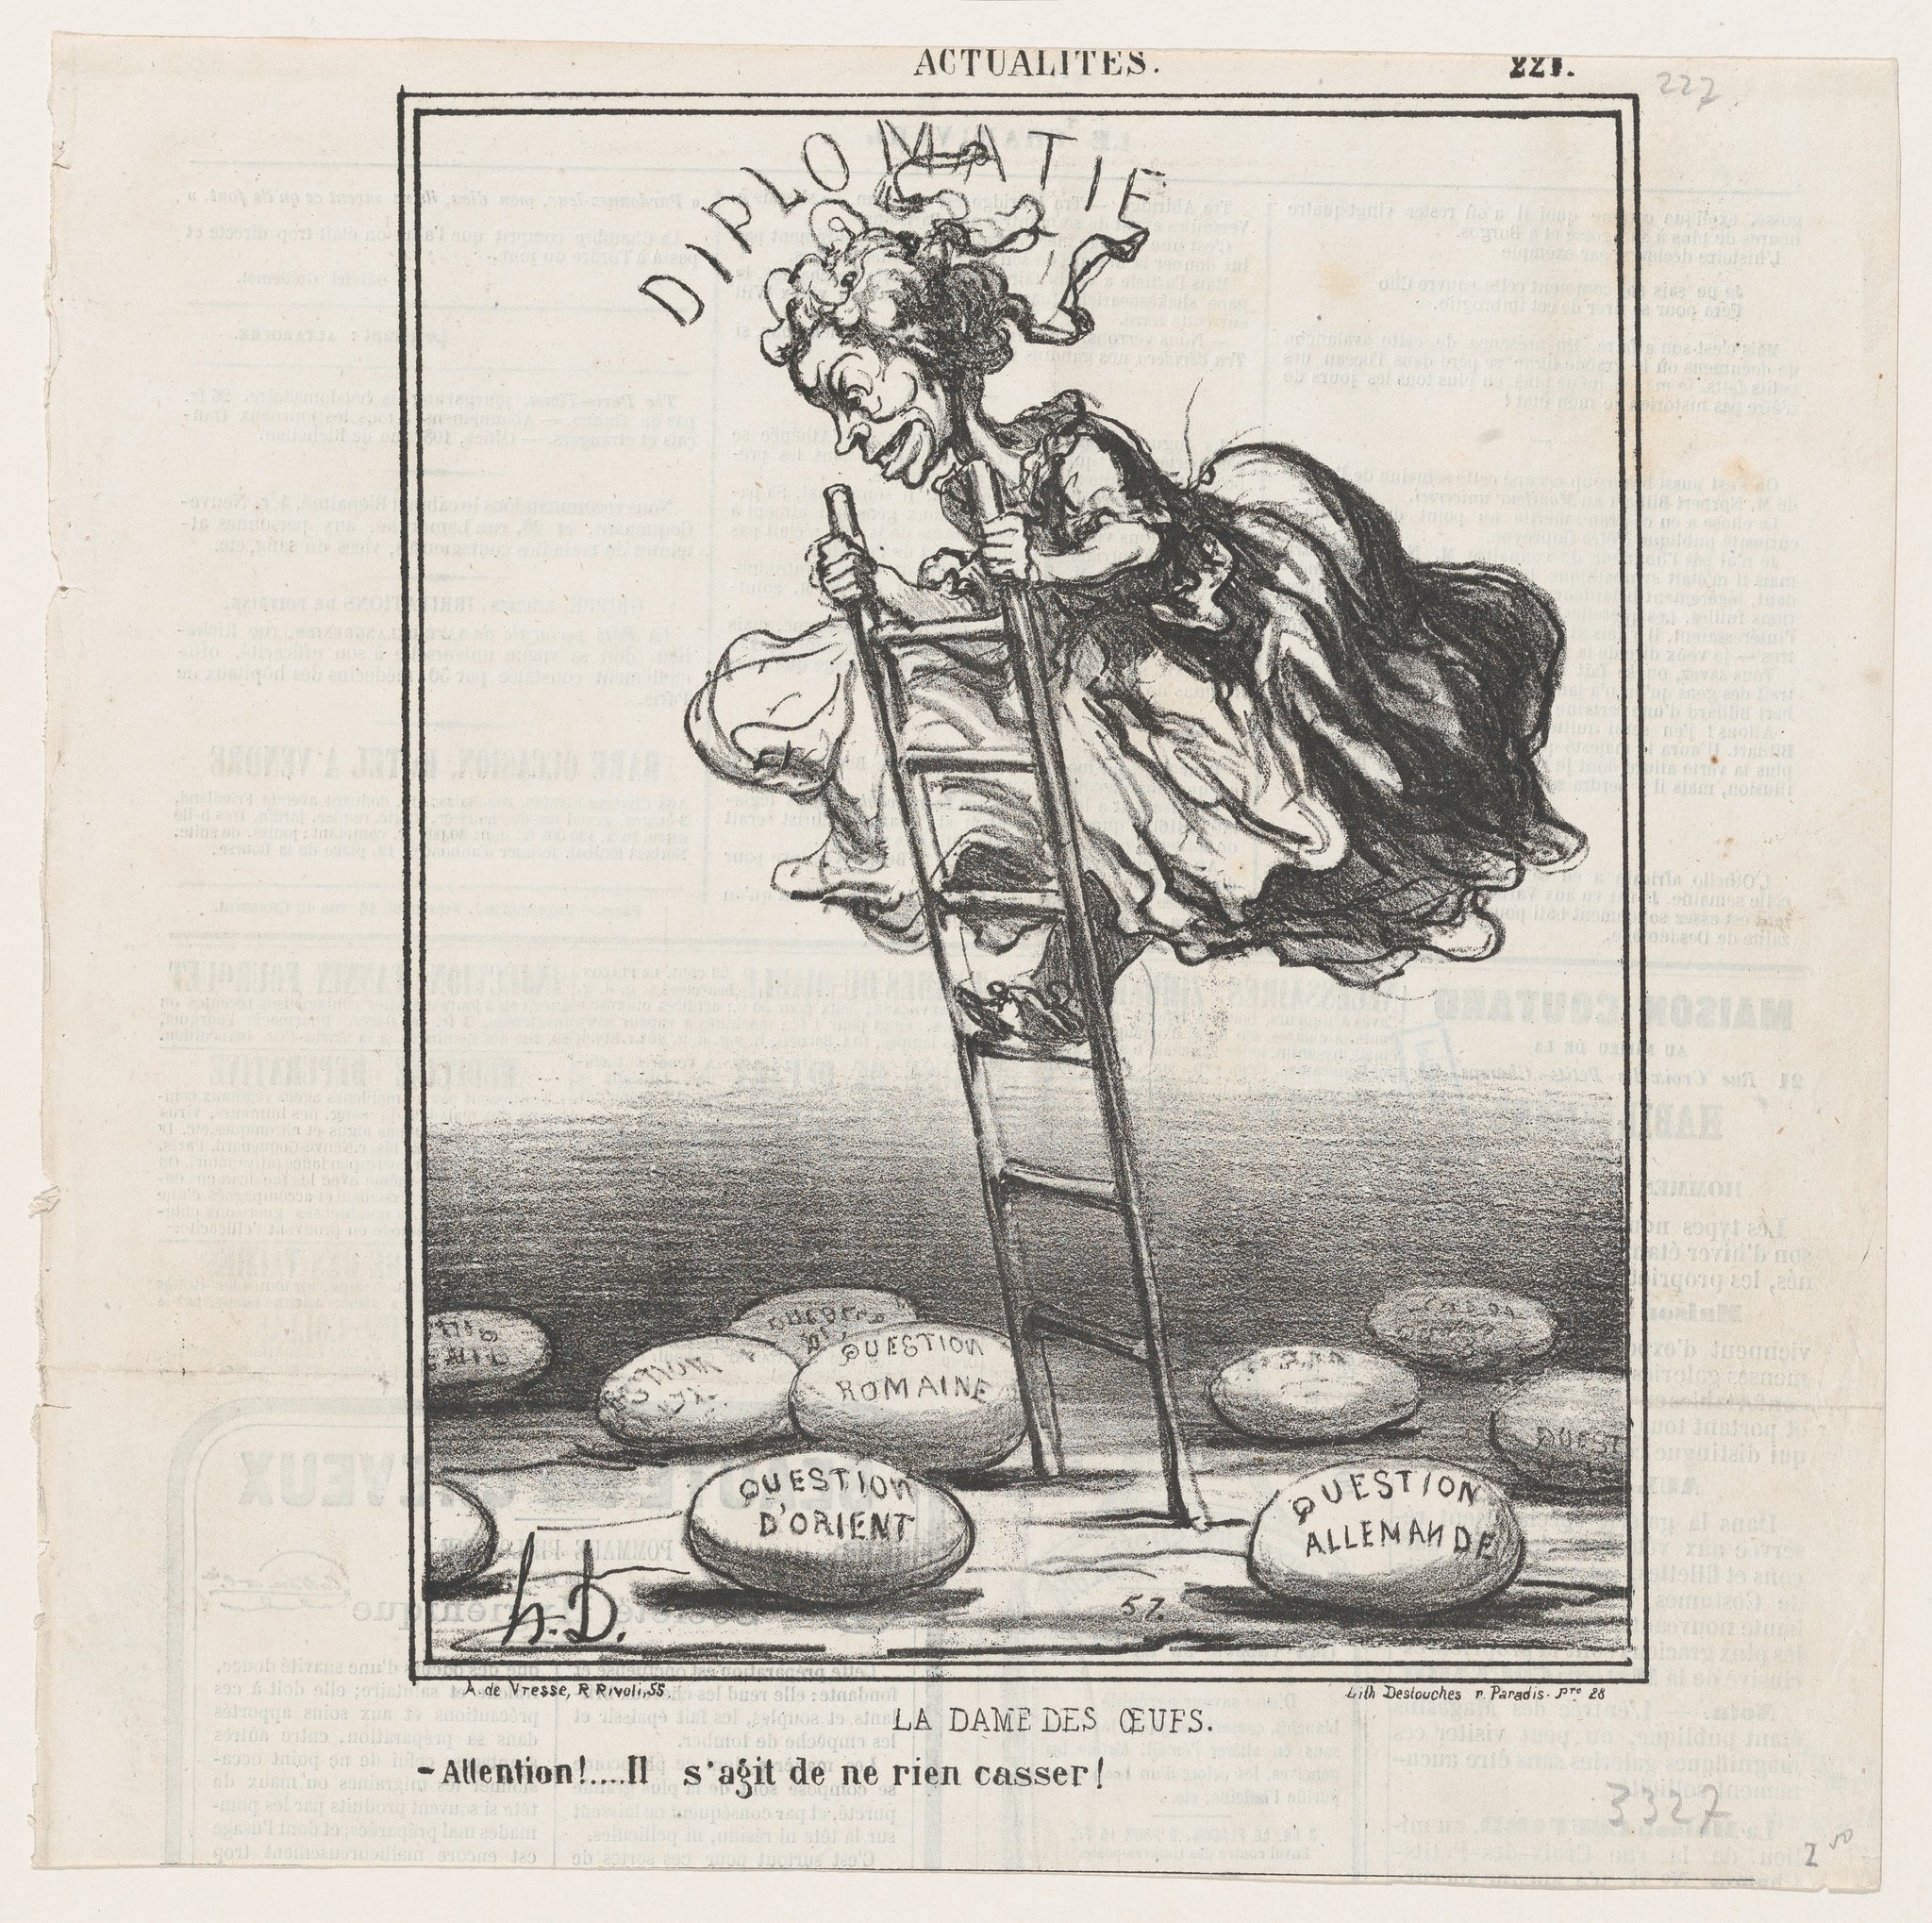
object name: print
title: The lady of the eggs: Watch out! It's important not to break any of them!, from 'News of the day,' published in "Le Charivari"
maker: honoré daumier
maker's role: artist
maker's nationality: french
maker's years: 1808-1879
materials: paper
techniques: lithograph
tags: satire,women,ladders,eggs